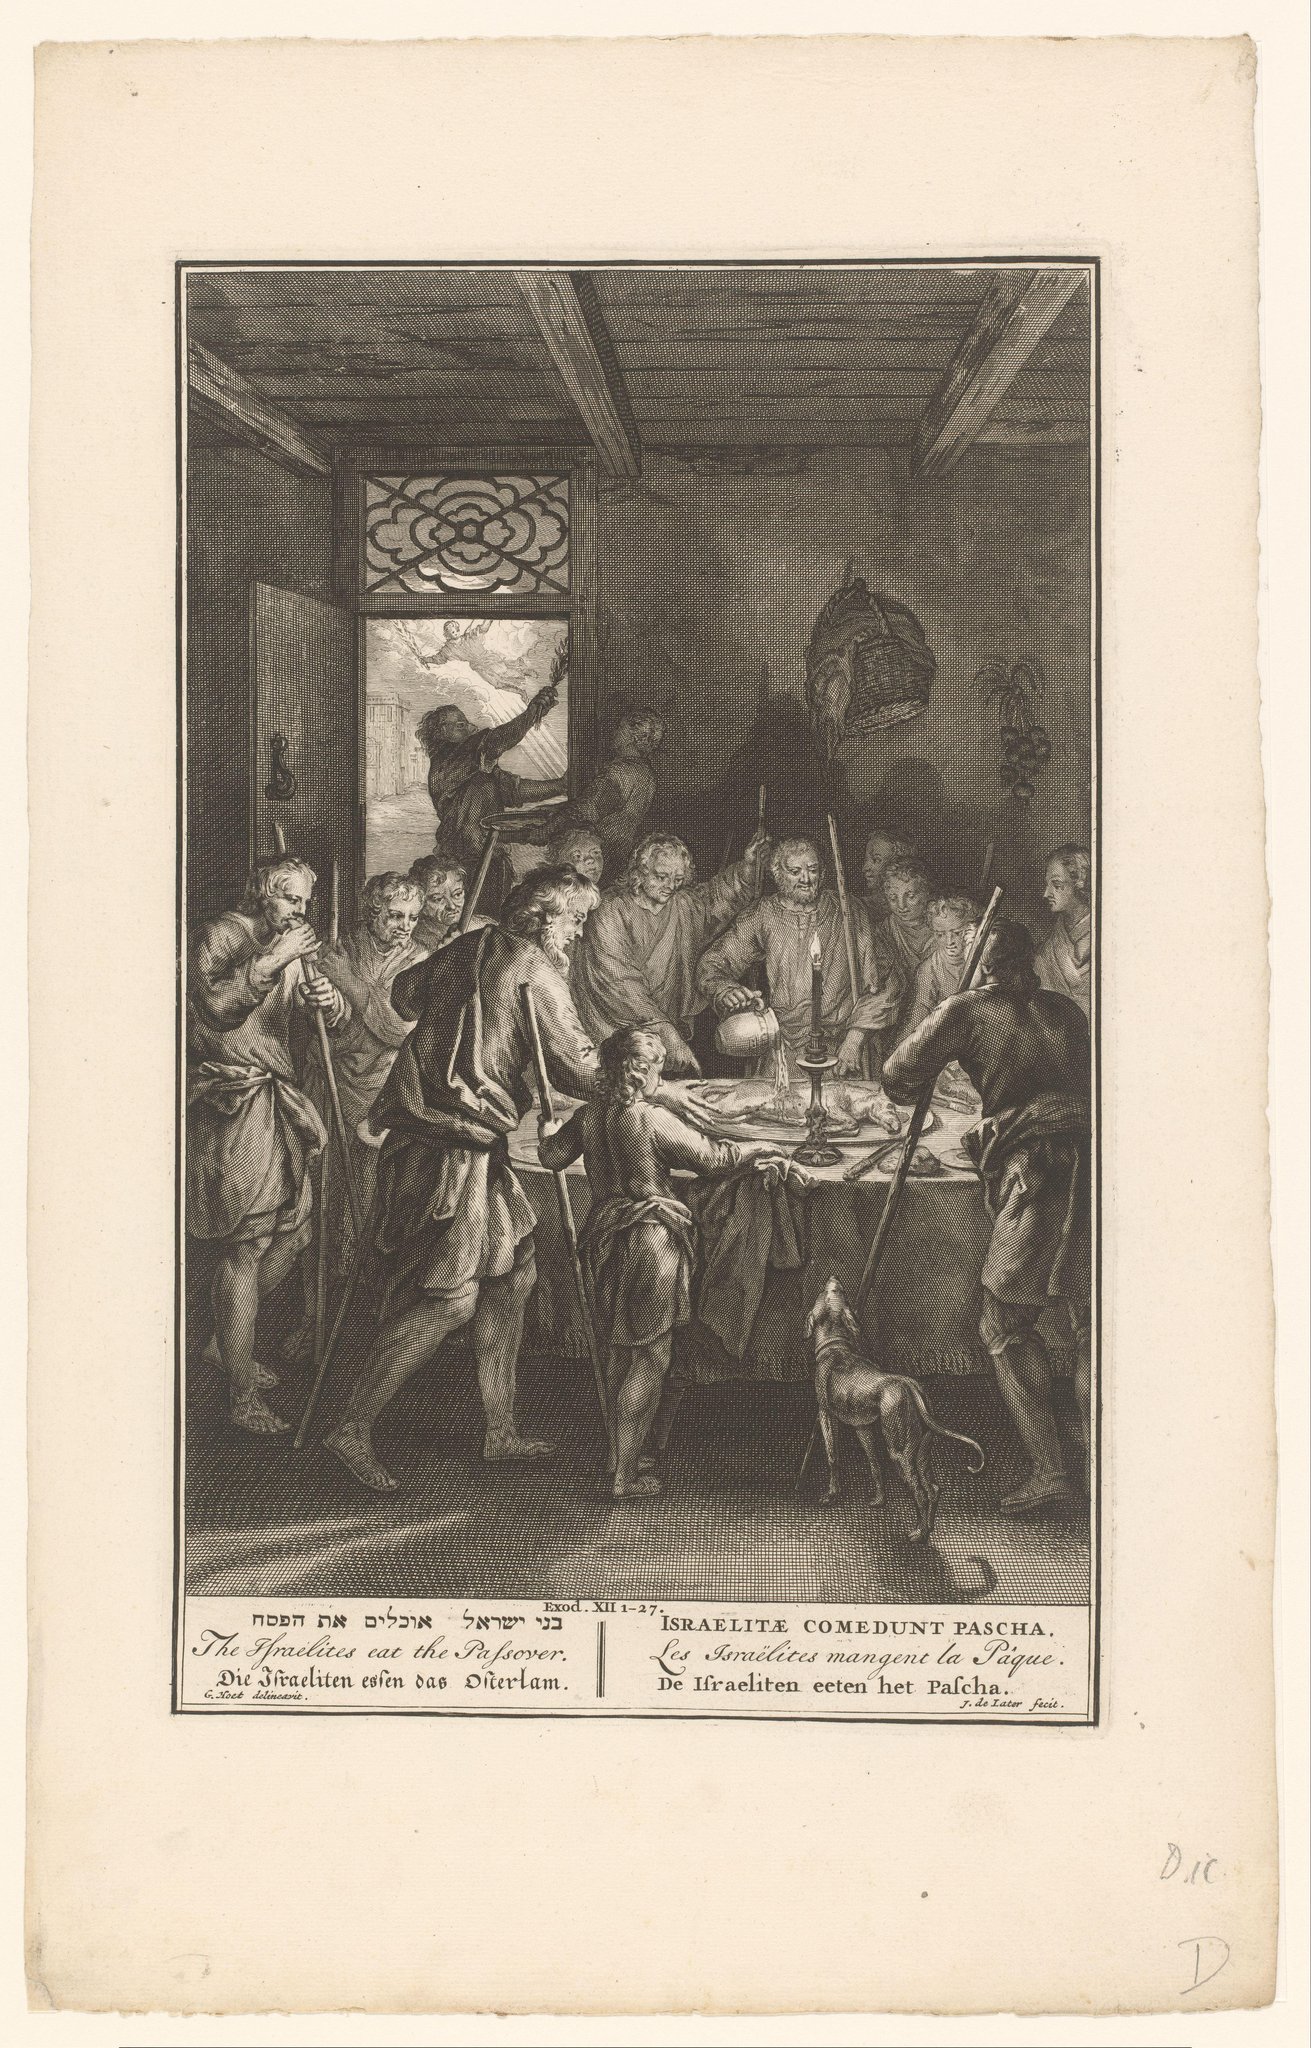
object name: print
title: Paschaviering in Egypte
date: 1720-1728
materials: paper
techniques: engraving, etching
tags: the israelites eat the passover lamb standing about a table with their loins girt, their shoes on their feet and with staves in their hands, ready to depart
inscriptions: inscription: ‘ütrechts Fündatie hüijs’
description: De Israëlieten staan rond een tafel en eten haastig het lam. Met schoenen aan hun voeten en stokken in hun handen zijn ze klaar om te vertrekken uit hun ballingschap. Op de achtergrond wordt op de deurpost een teken met bloed aangebracht. Bijbelse voorstelling uit Ex. 12:1-27 met in de marge de titel van de voorstelling in zes talen.